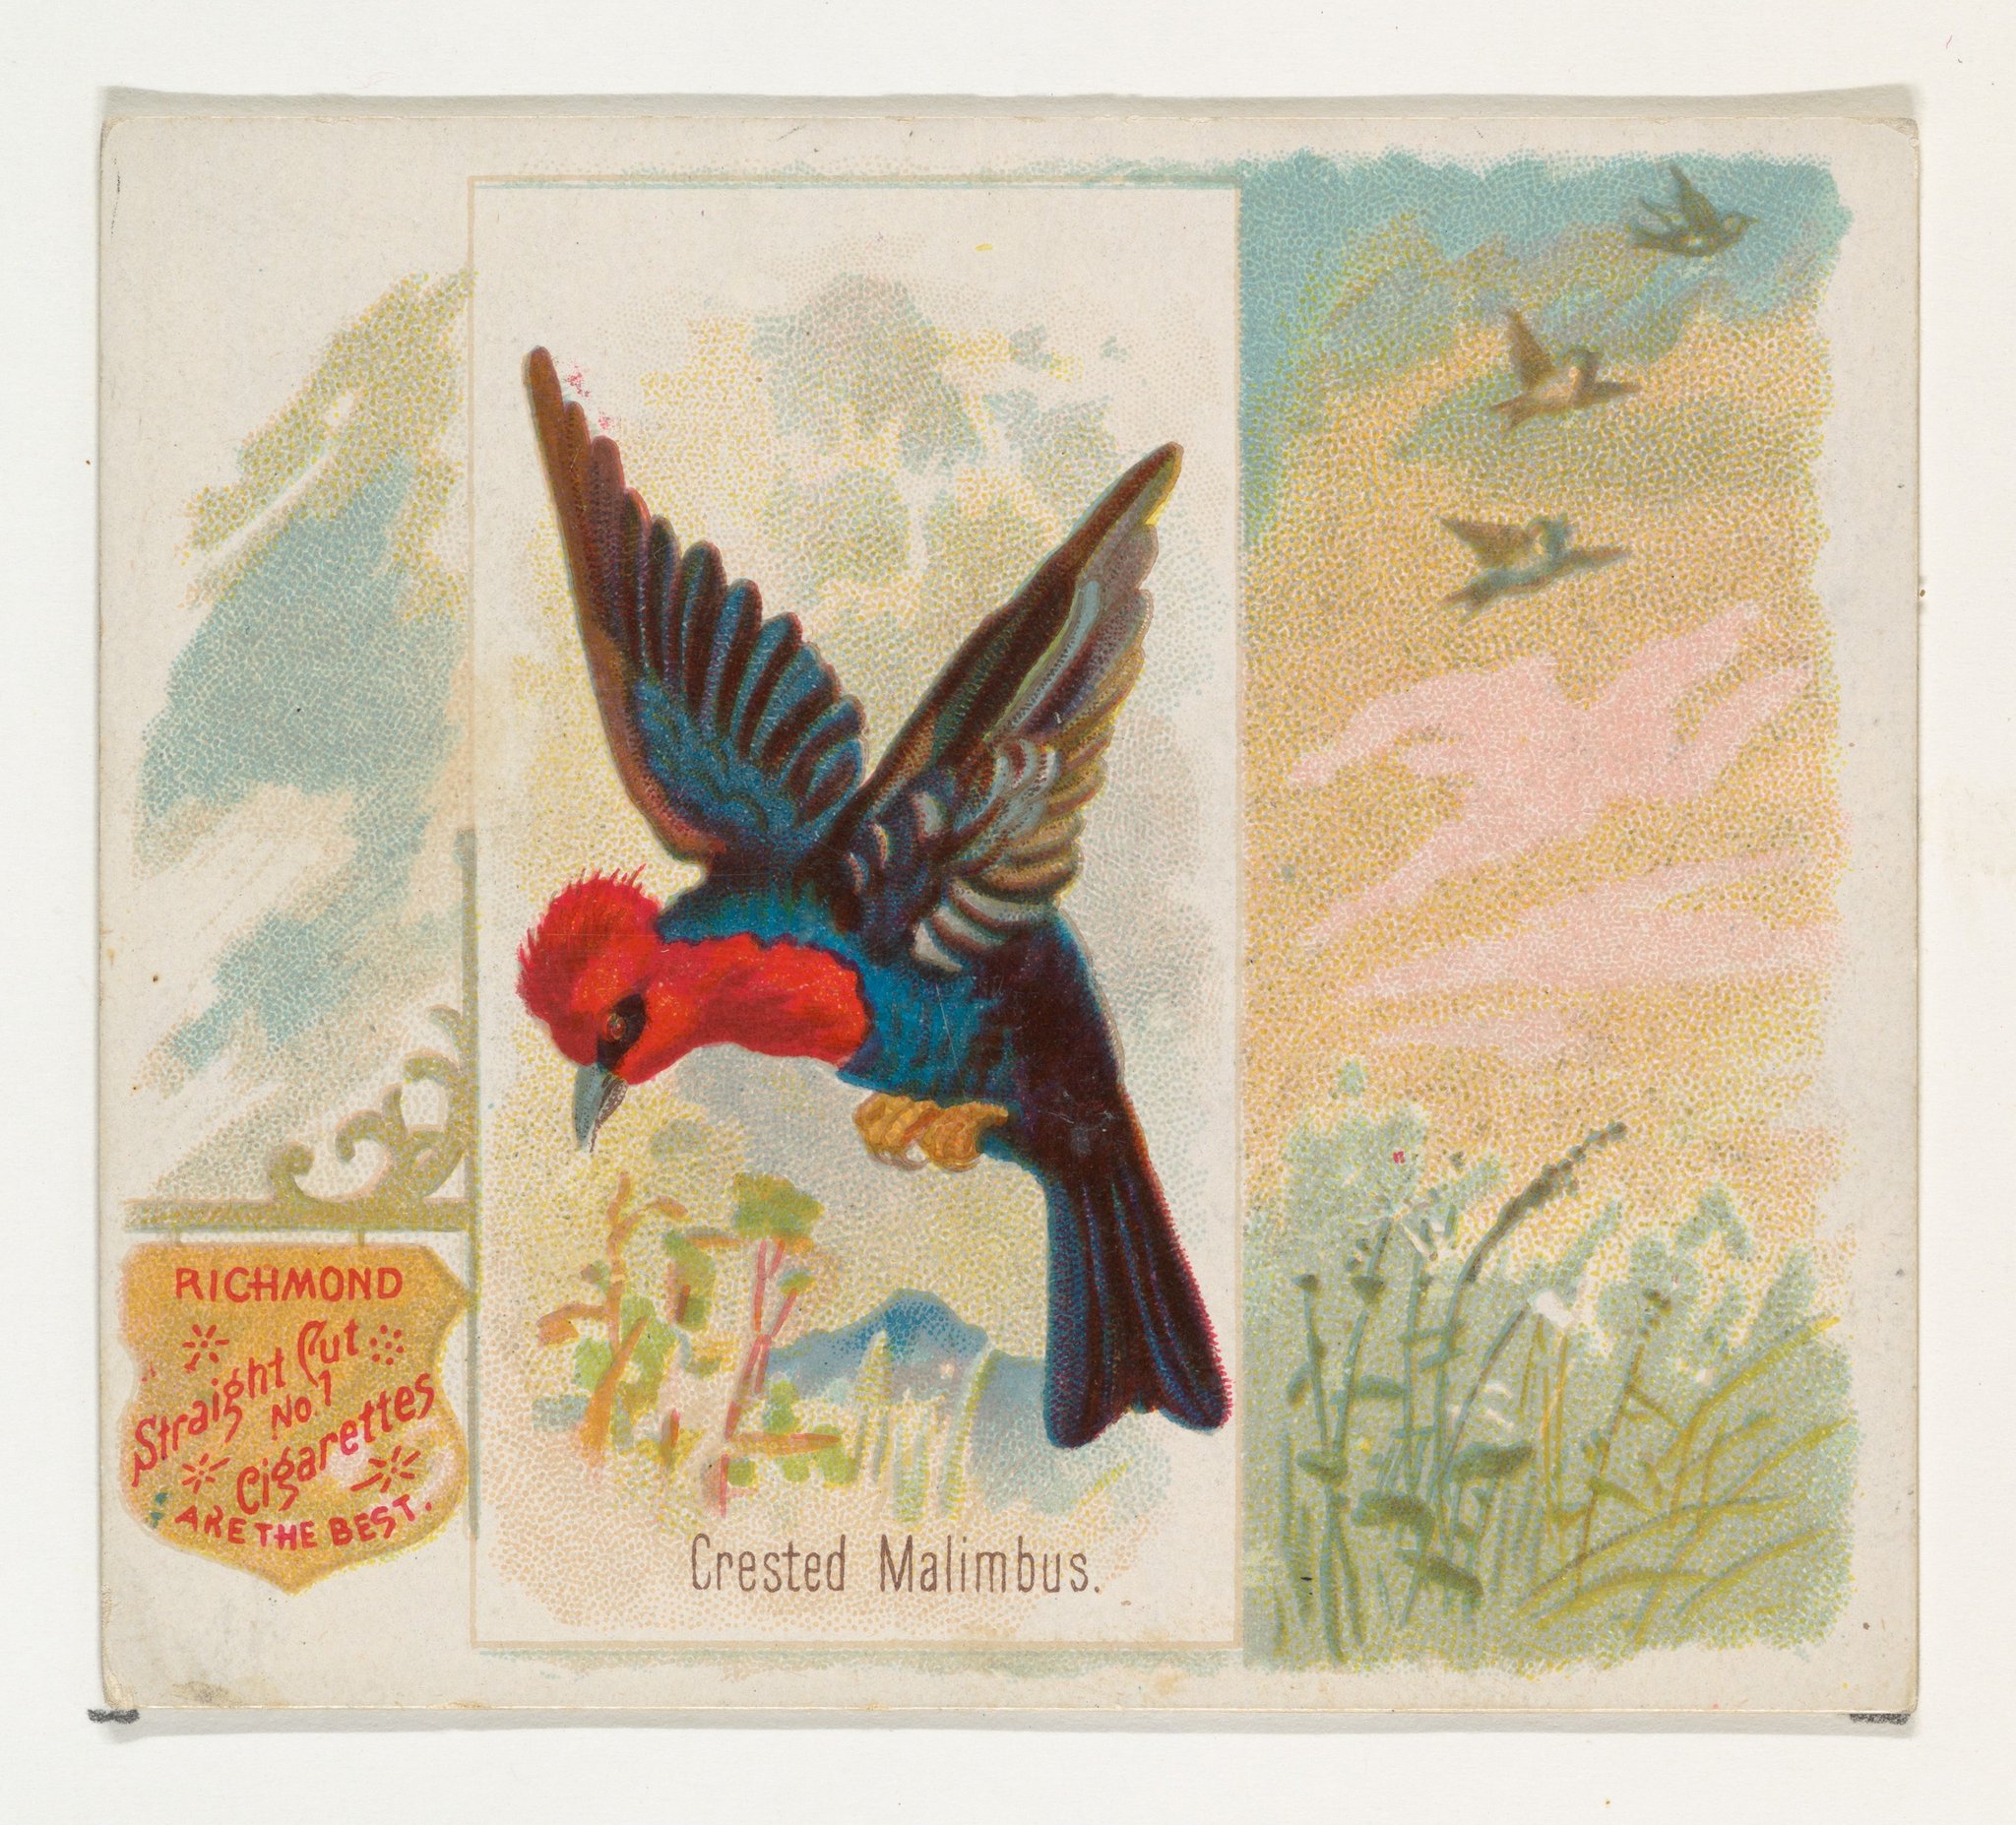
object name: print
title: Crested Malimbus, from the Song Birds of the World series (N42) for Allen & Ginter Cigarettes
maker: allen & ginter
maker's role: publisher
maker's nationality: american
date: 1890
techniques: color lithograph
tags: birds